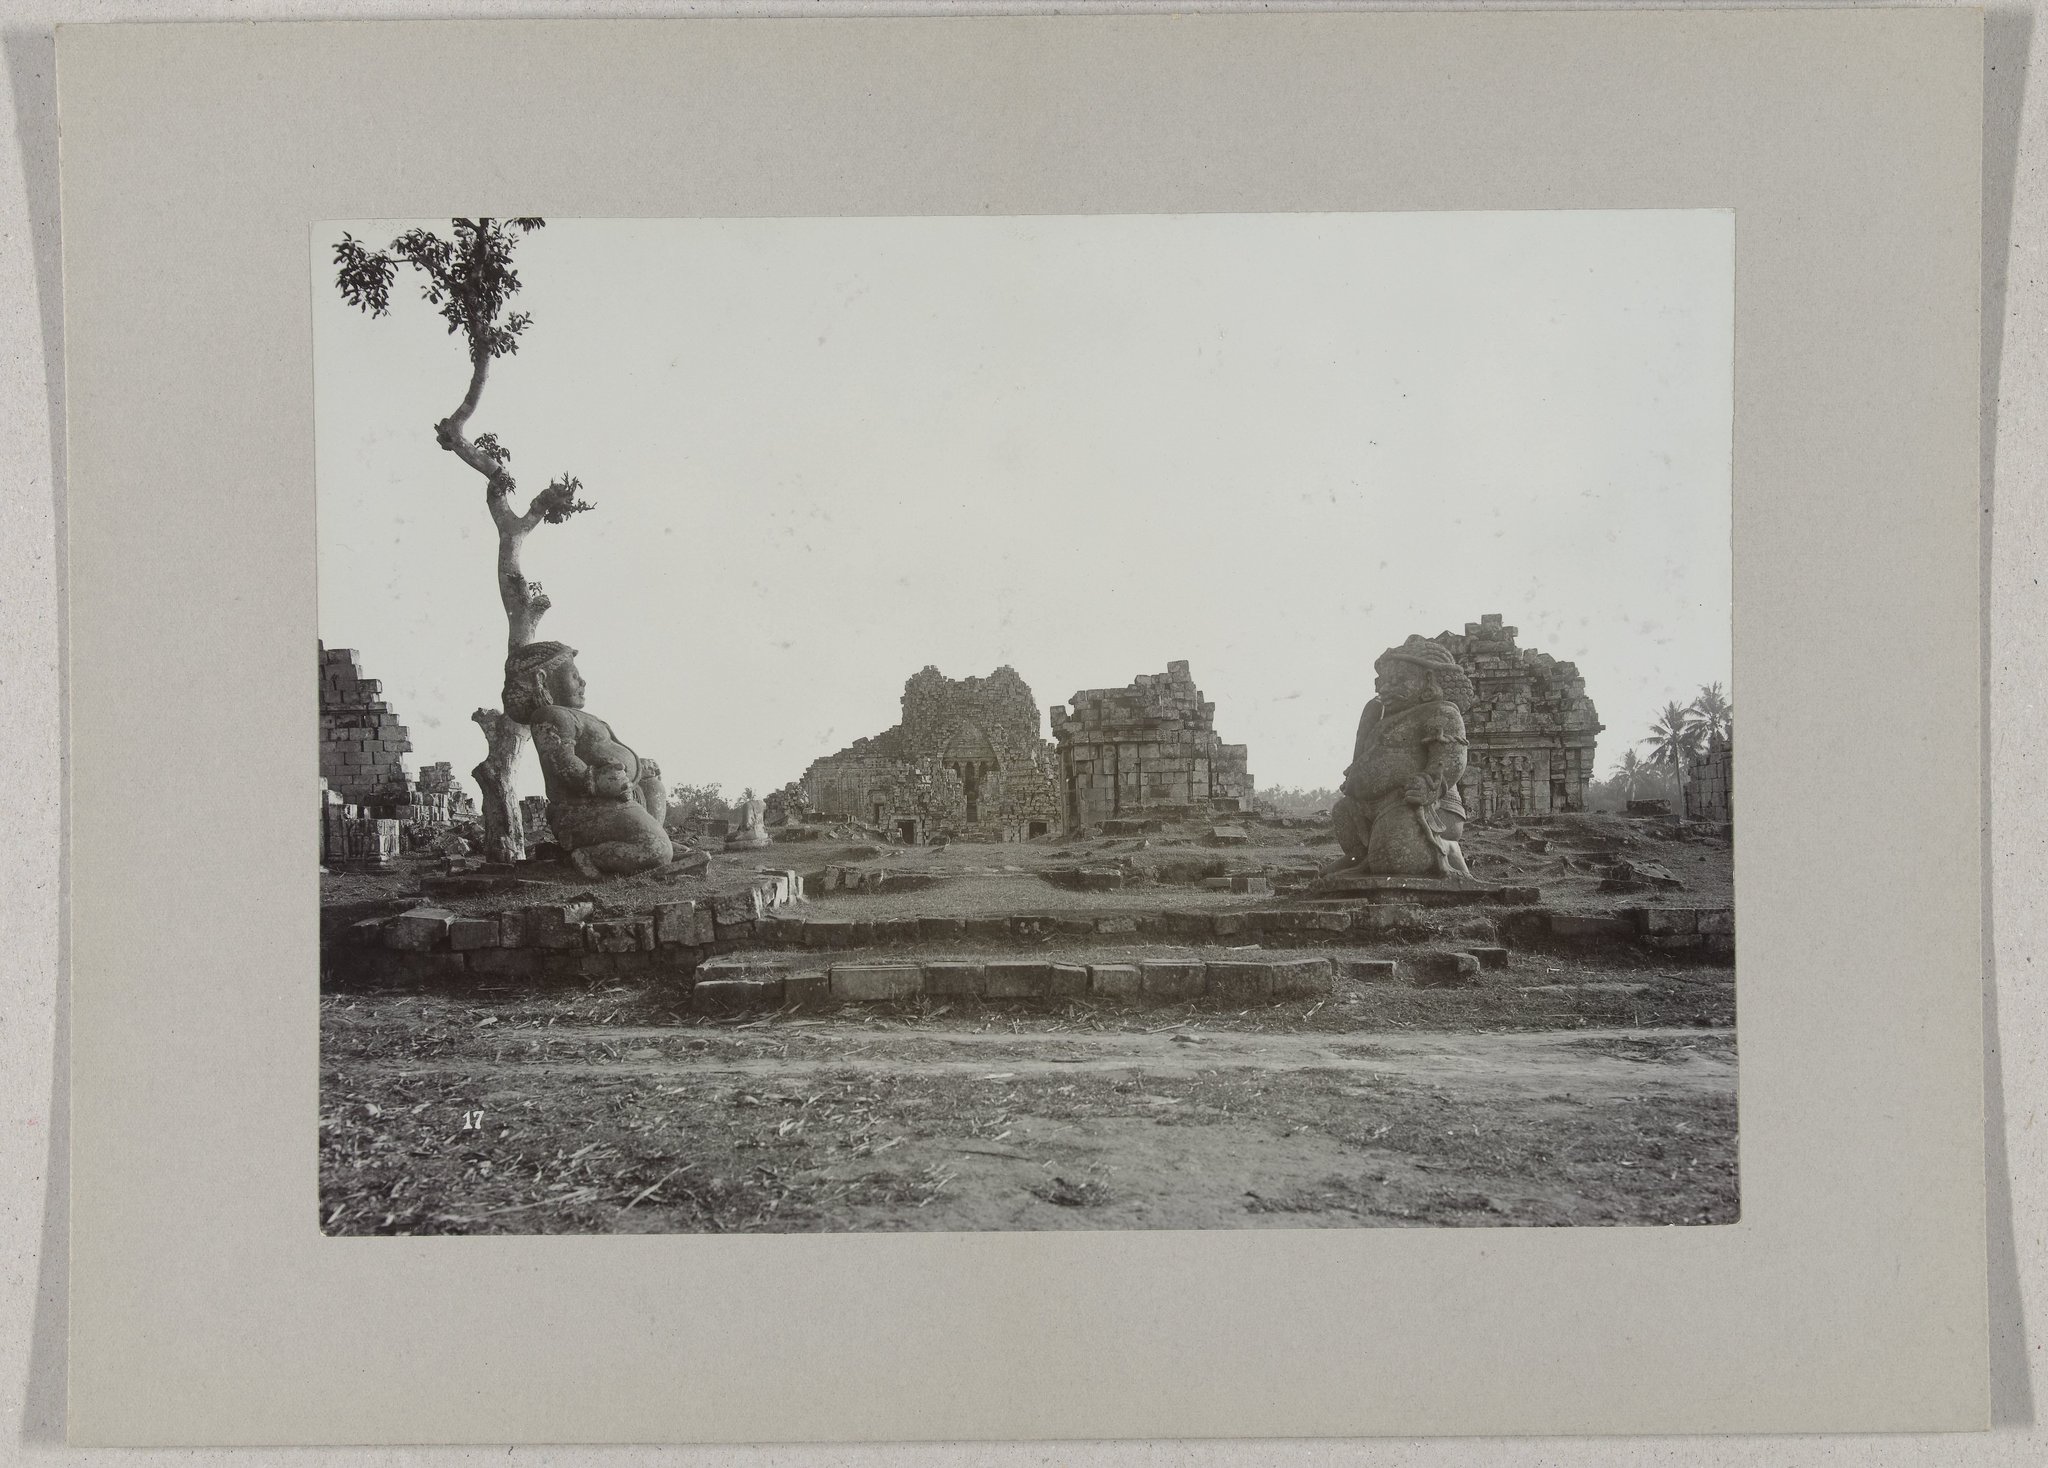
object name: photograph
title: Candi Sewu with Statues of Temple Guardians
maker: kassian céphas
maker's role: fotograaf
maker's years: 1845-1912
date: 1895-1915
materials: cardboard, paper, photographic support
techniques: gelatin silver print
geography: jogjakarta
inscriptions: annotation: ‘90. Tjandi sèwoe’, number: ‘17’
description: Like Kinsbergen before him, Céphas was commissioned by the Archaeological Society in Yogyakarta to photograph the excavations and remains of ancient temples. This shot focuses on two of the enormous temple guards that even now keep watch over the four main entrances of the Buddhist temple of Candi Sewu.